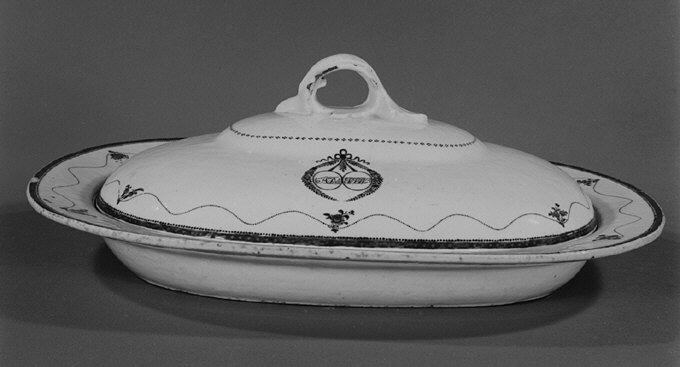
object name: platter with cover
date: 1790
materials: hard paste porcelain